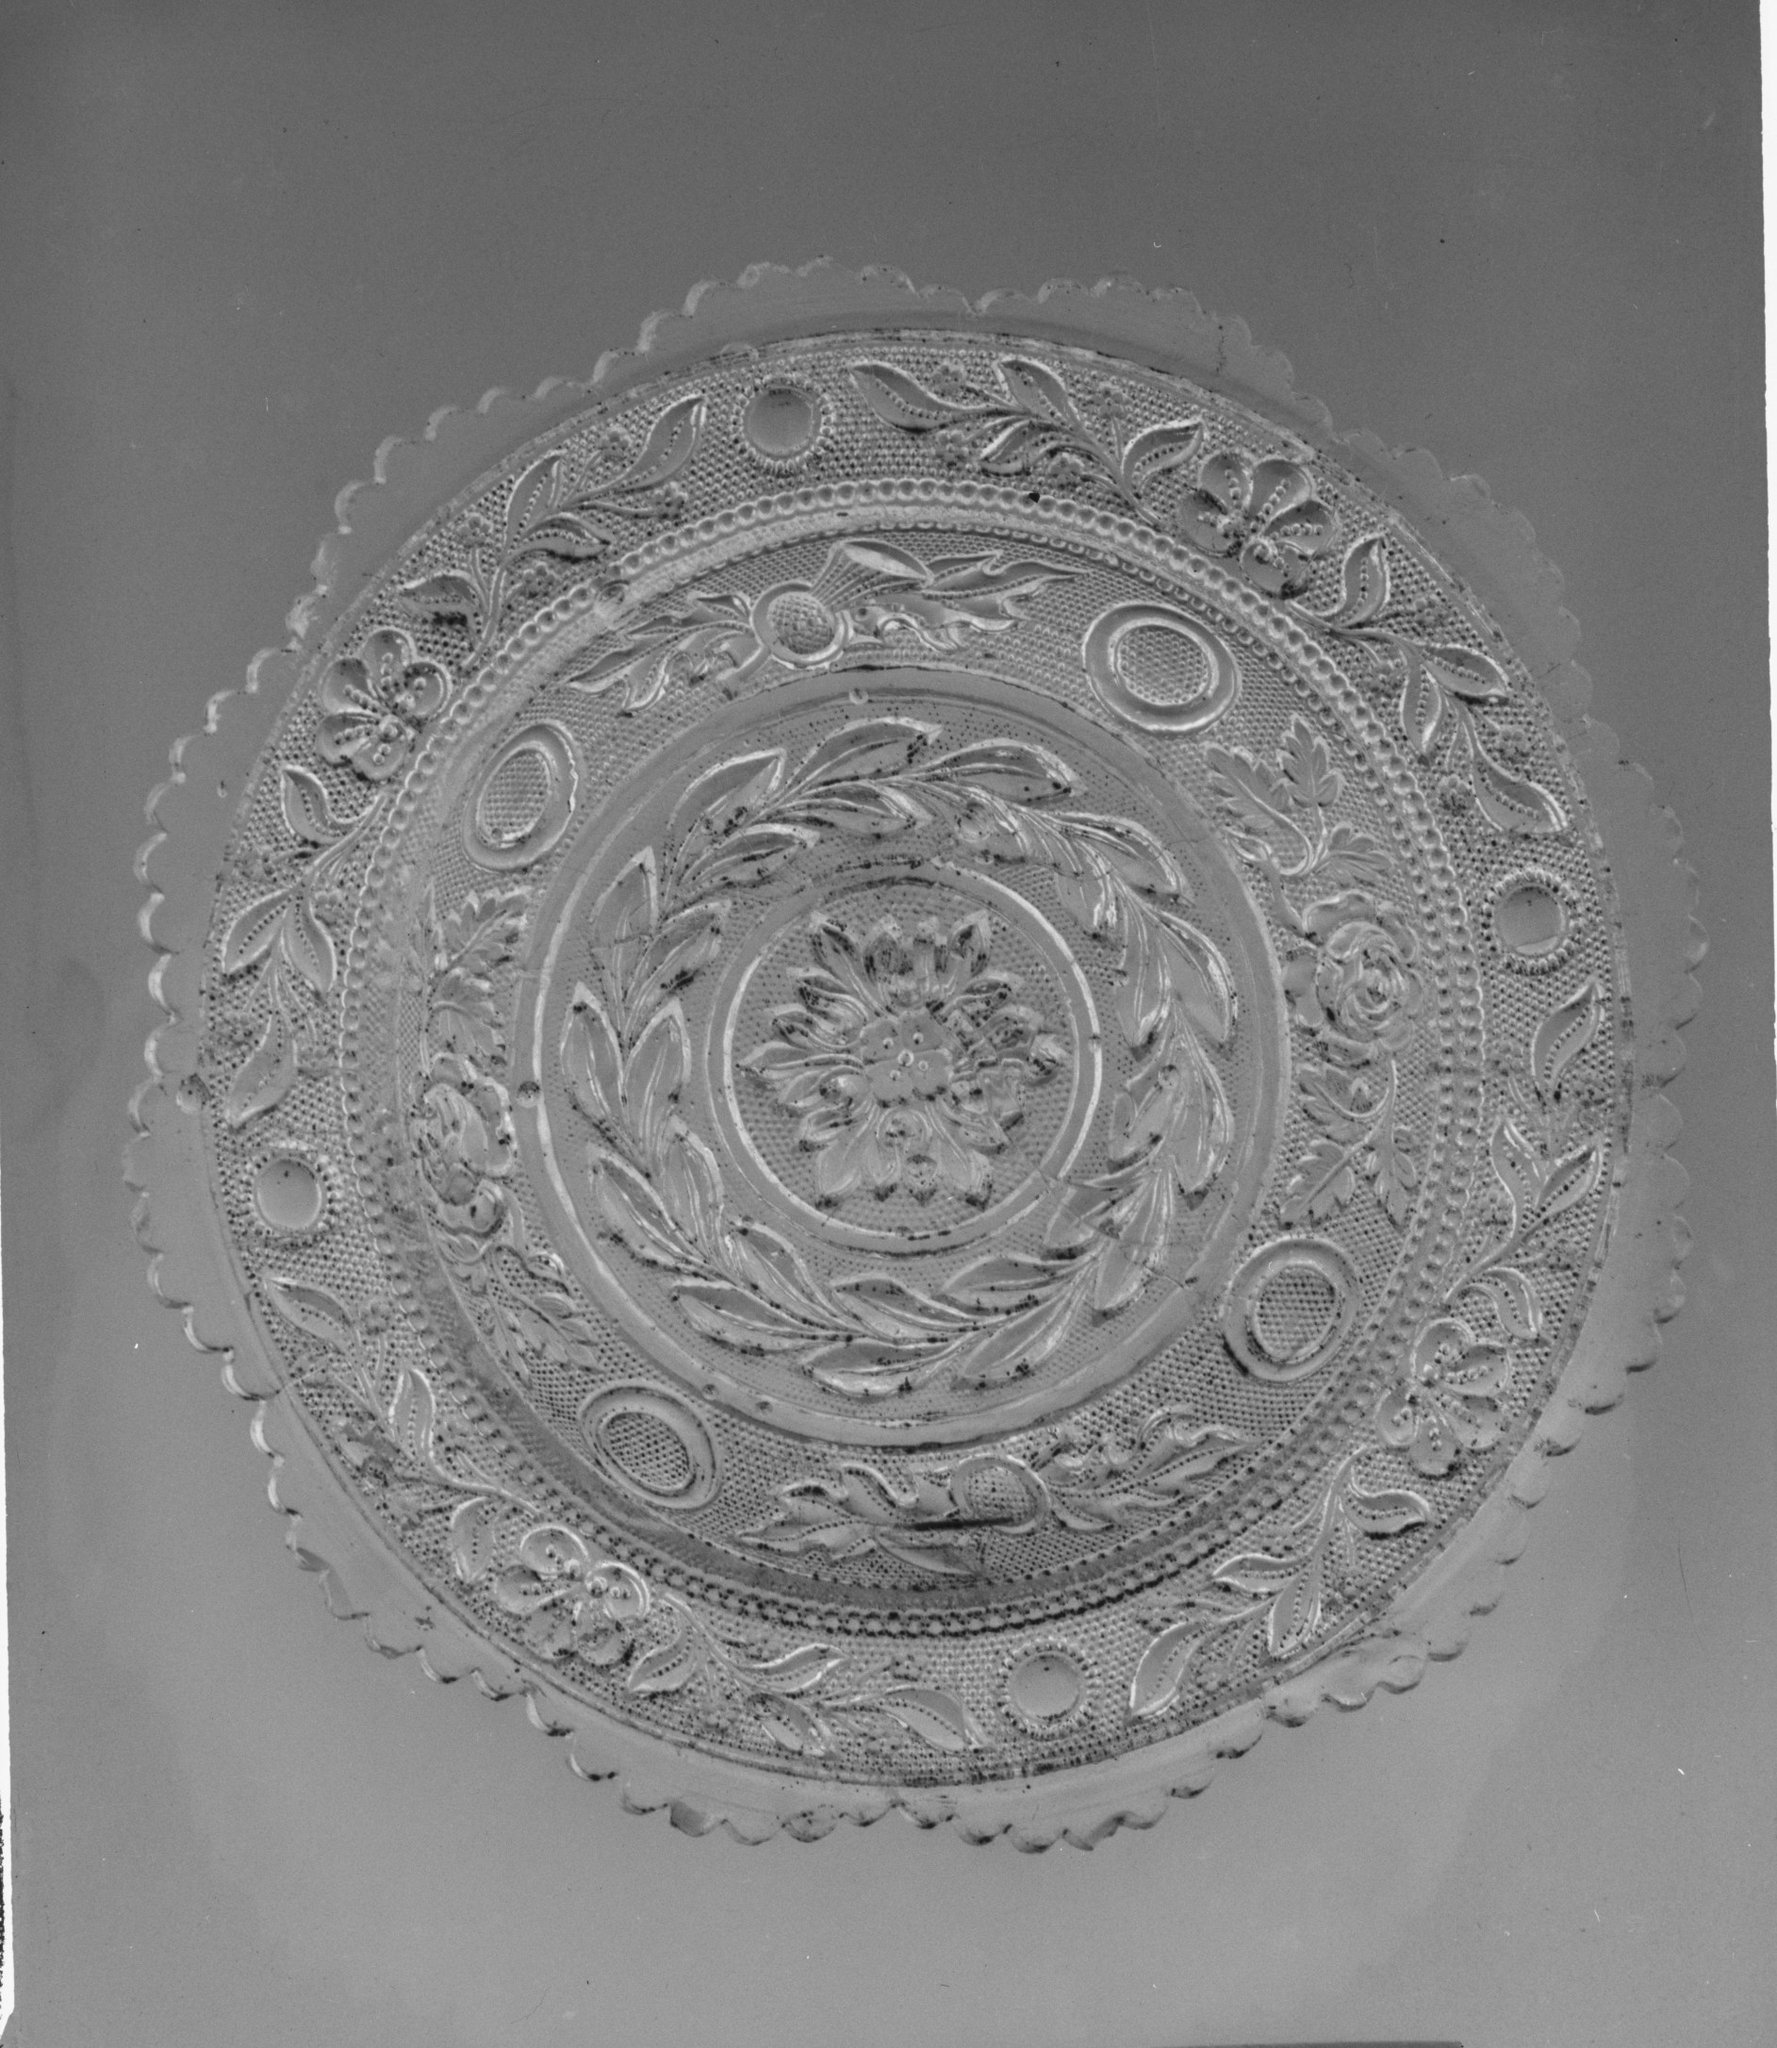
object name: plate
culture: american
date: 1840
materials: glass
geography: united states